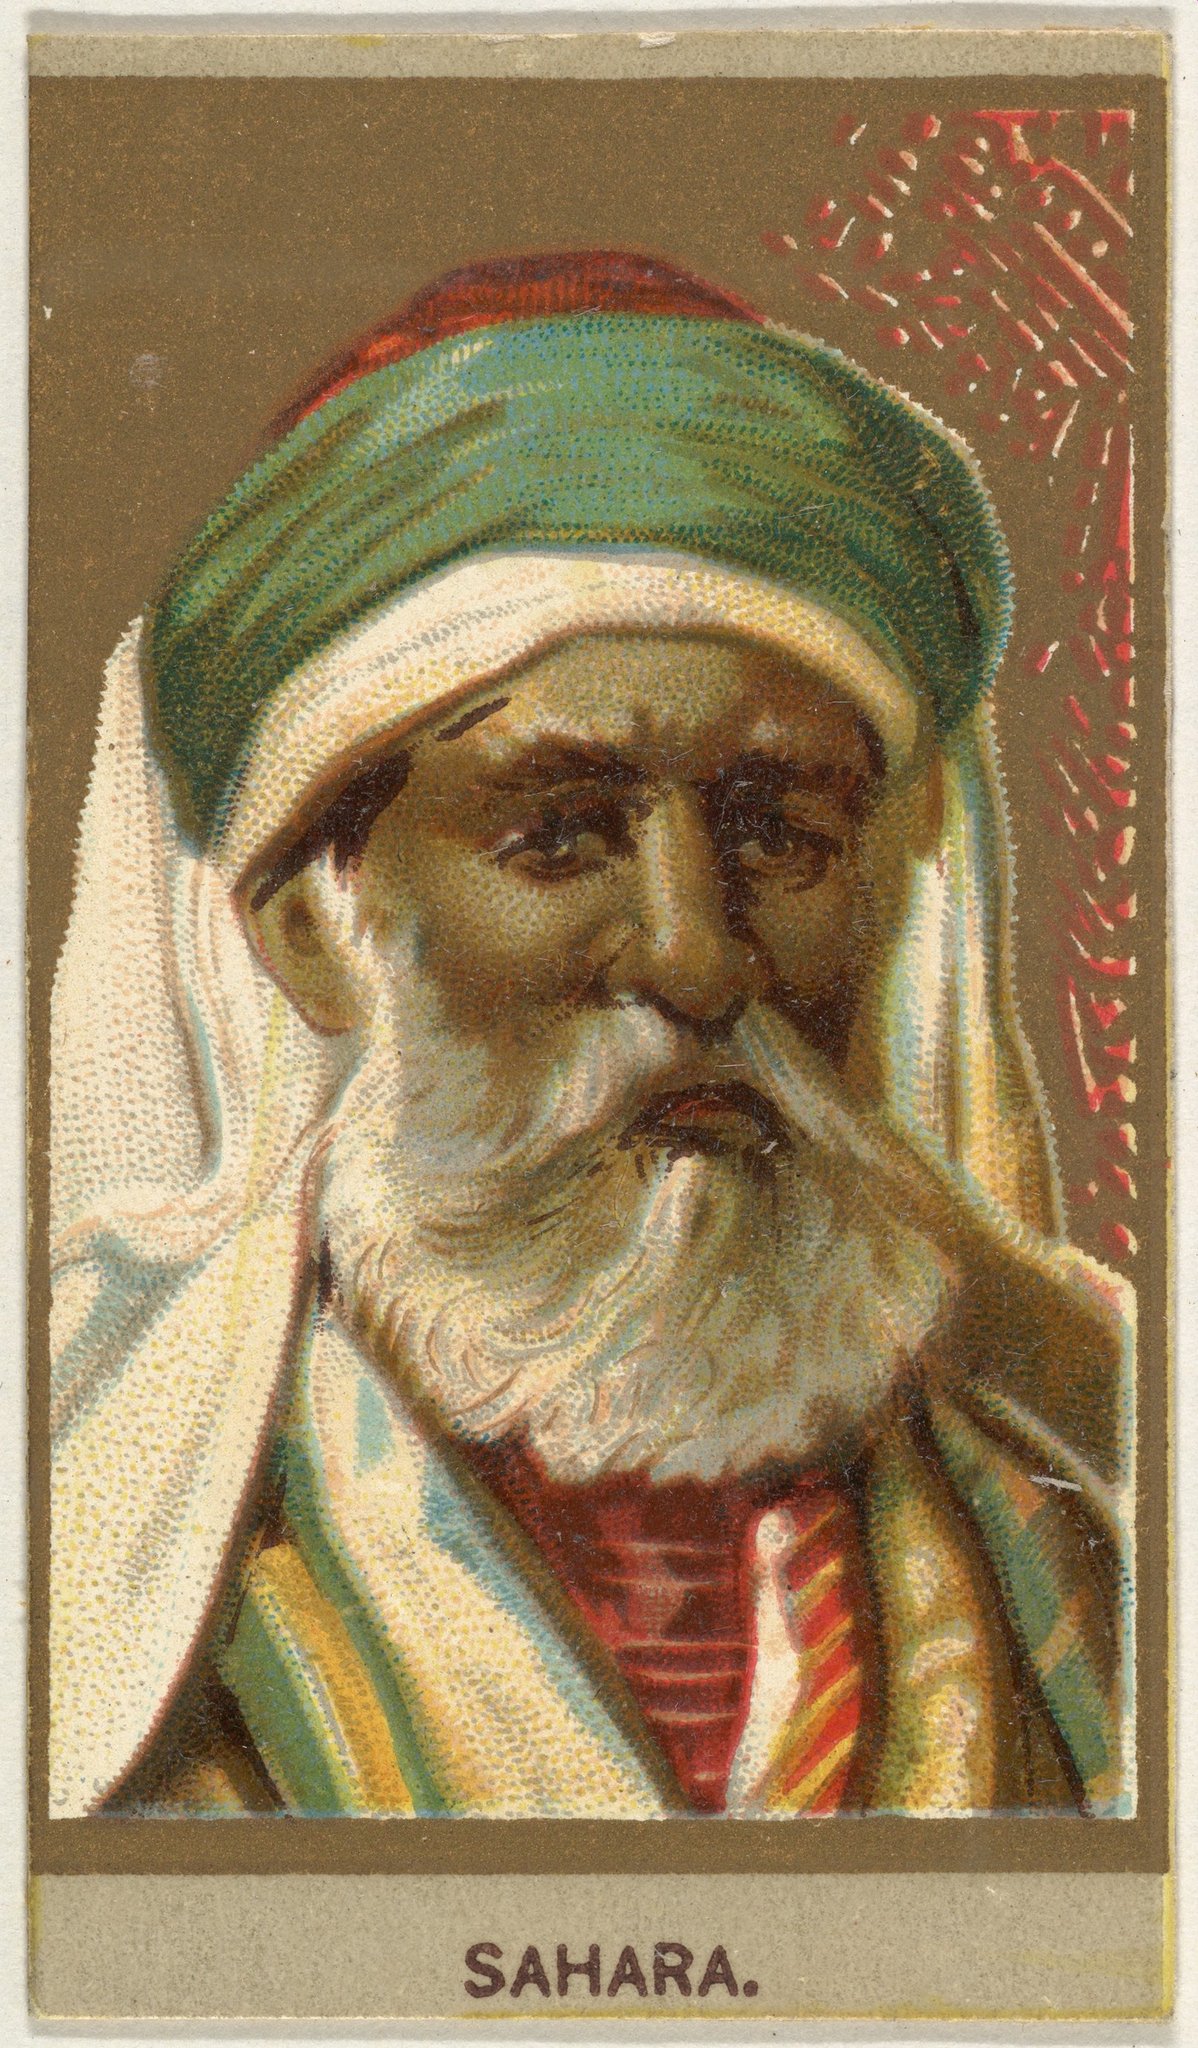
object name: print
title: Sahara, from the Races of Mankind series (T181) issued by Abdul Cigarettes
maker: abdul cigarettes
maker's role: publisher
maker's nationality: american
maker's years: 1881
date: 1881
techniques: color lithograph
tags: men